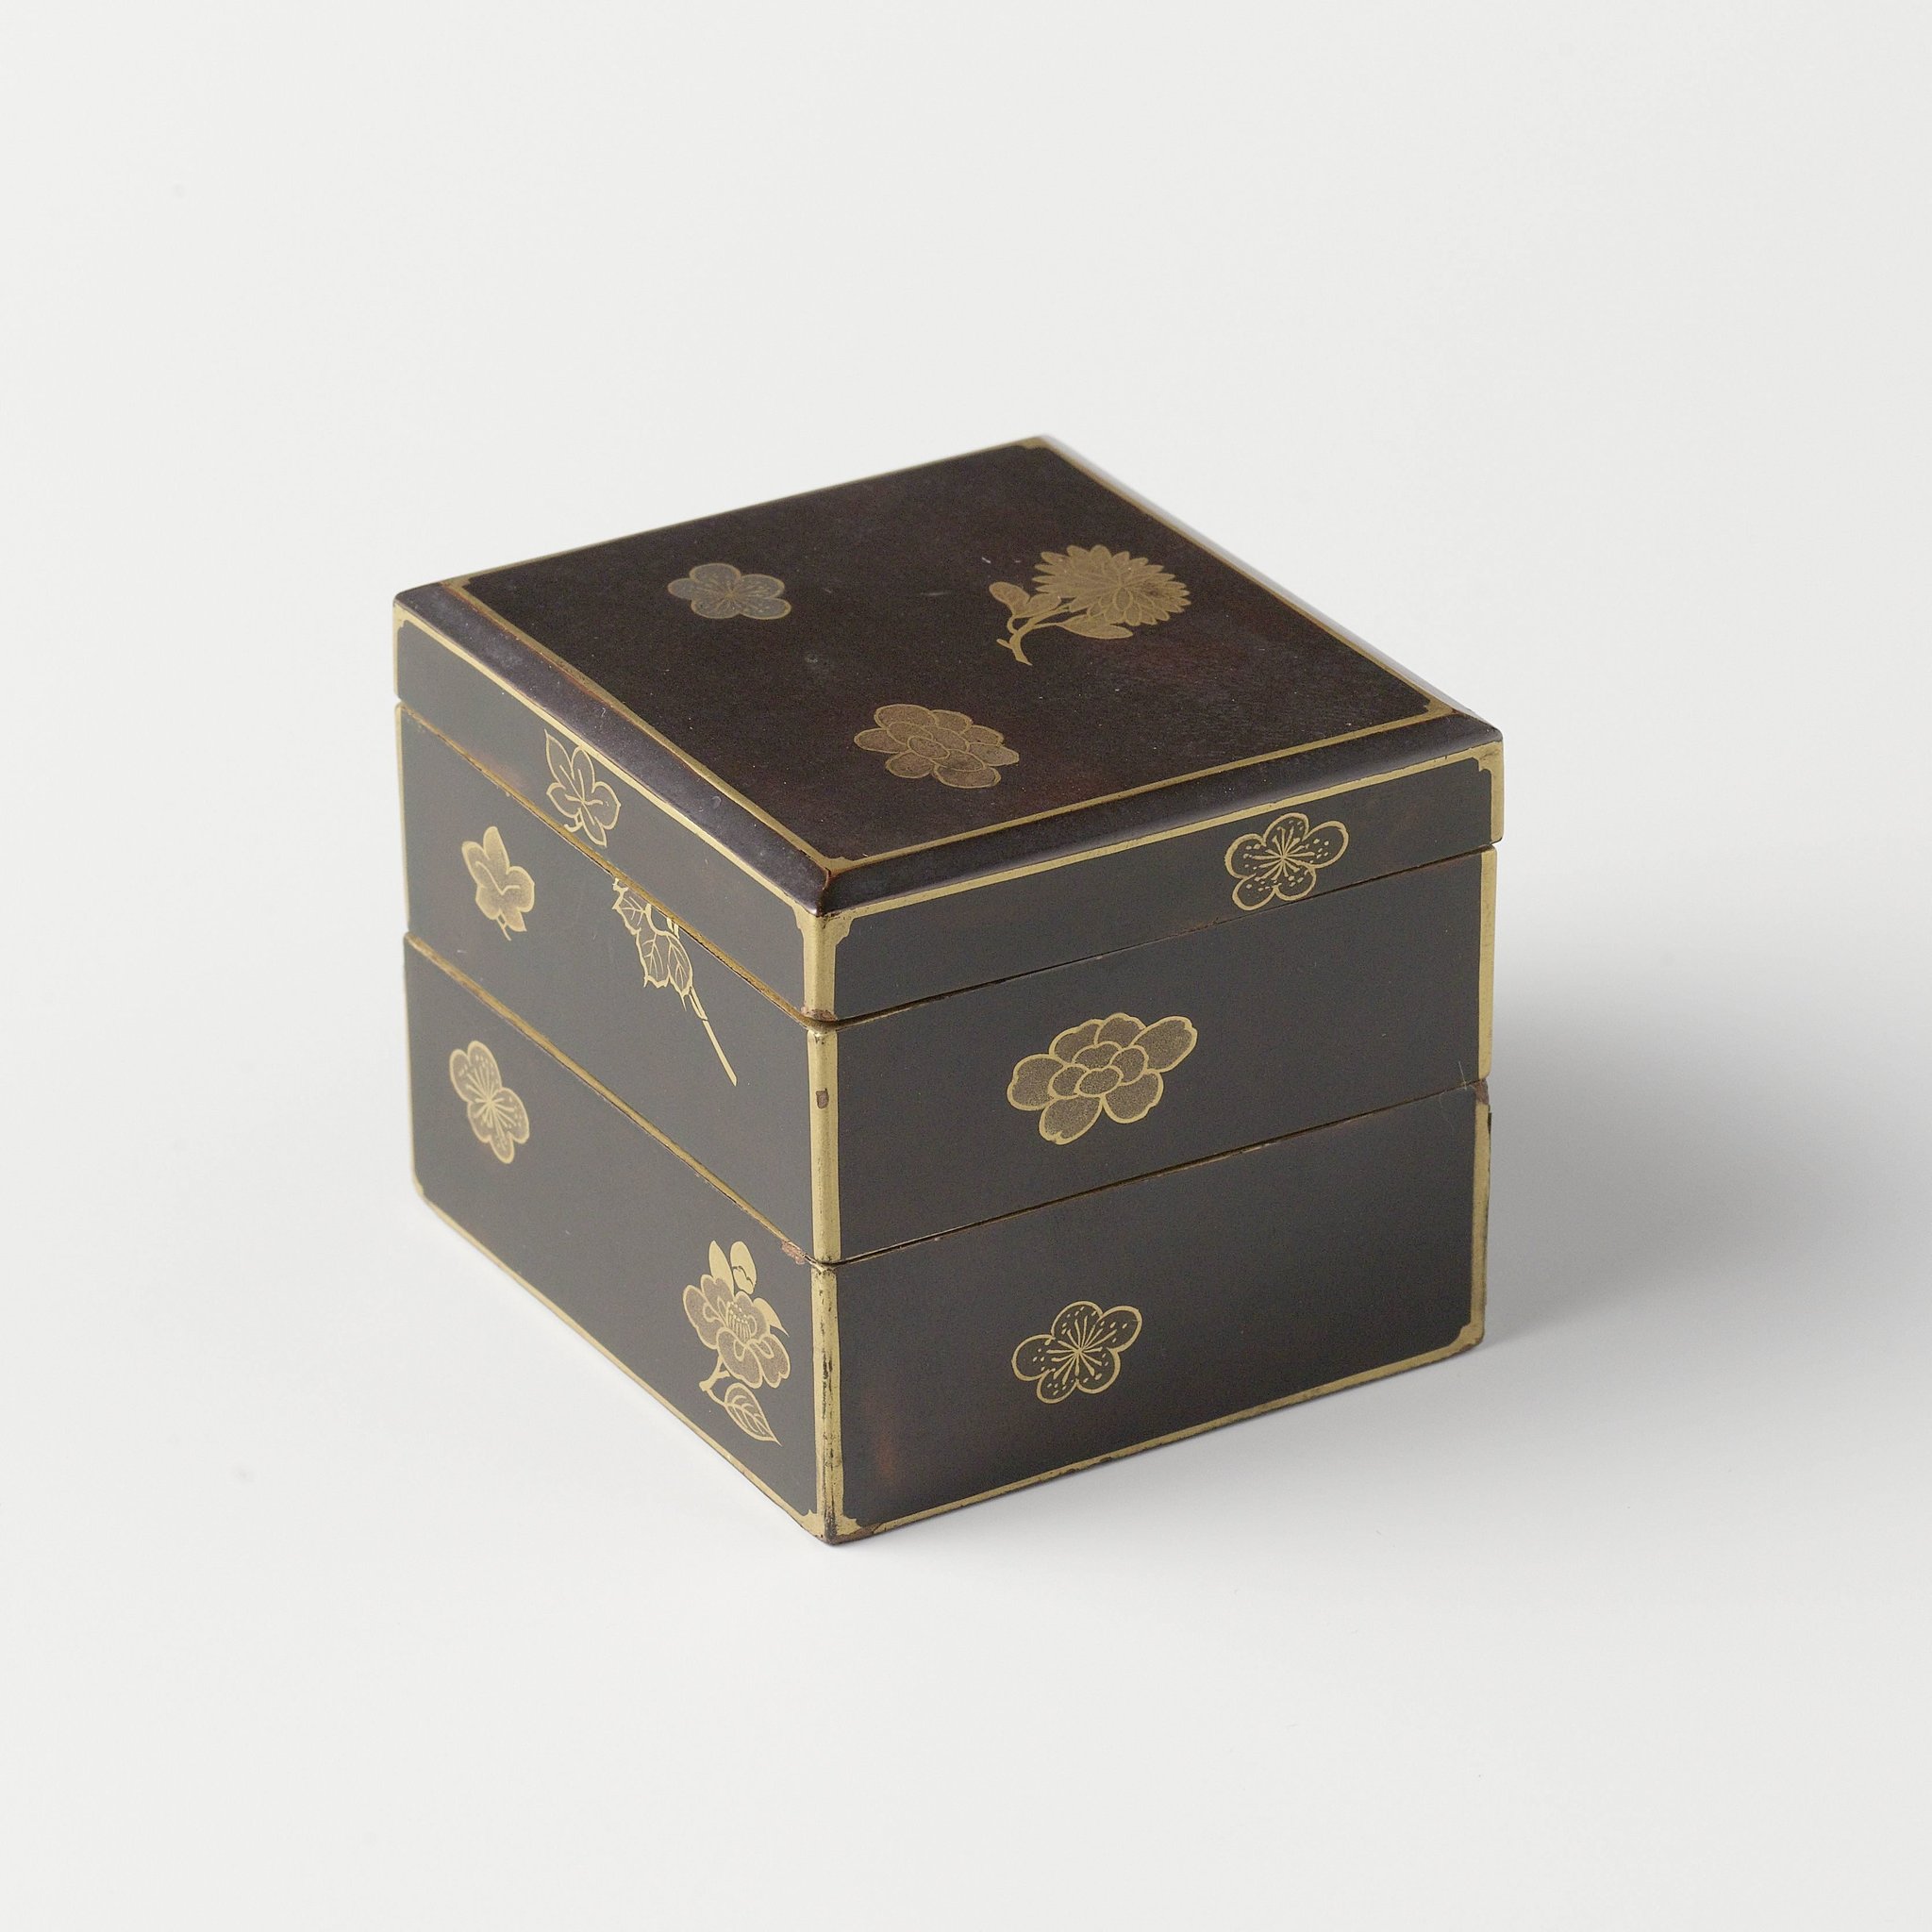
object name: box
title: Vierkante stapeldoos, zwarte lak met strooibloemen in goud-makie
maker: Anonymous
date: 1700-1800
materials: gold, lacquer, wood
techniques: lacquer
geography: japan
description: Vierkante stapeldoos met twee bakjes en een vlakke deksel (waarschijnlijk ontbreekt één bak). Zwarte lak met strooibloemen in goud-makie. Smalle gouden banden omranden de zijden en het deksel.